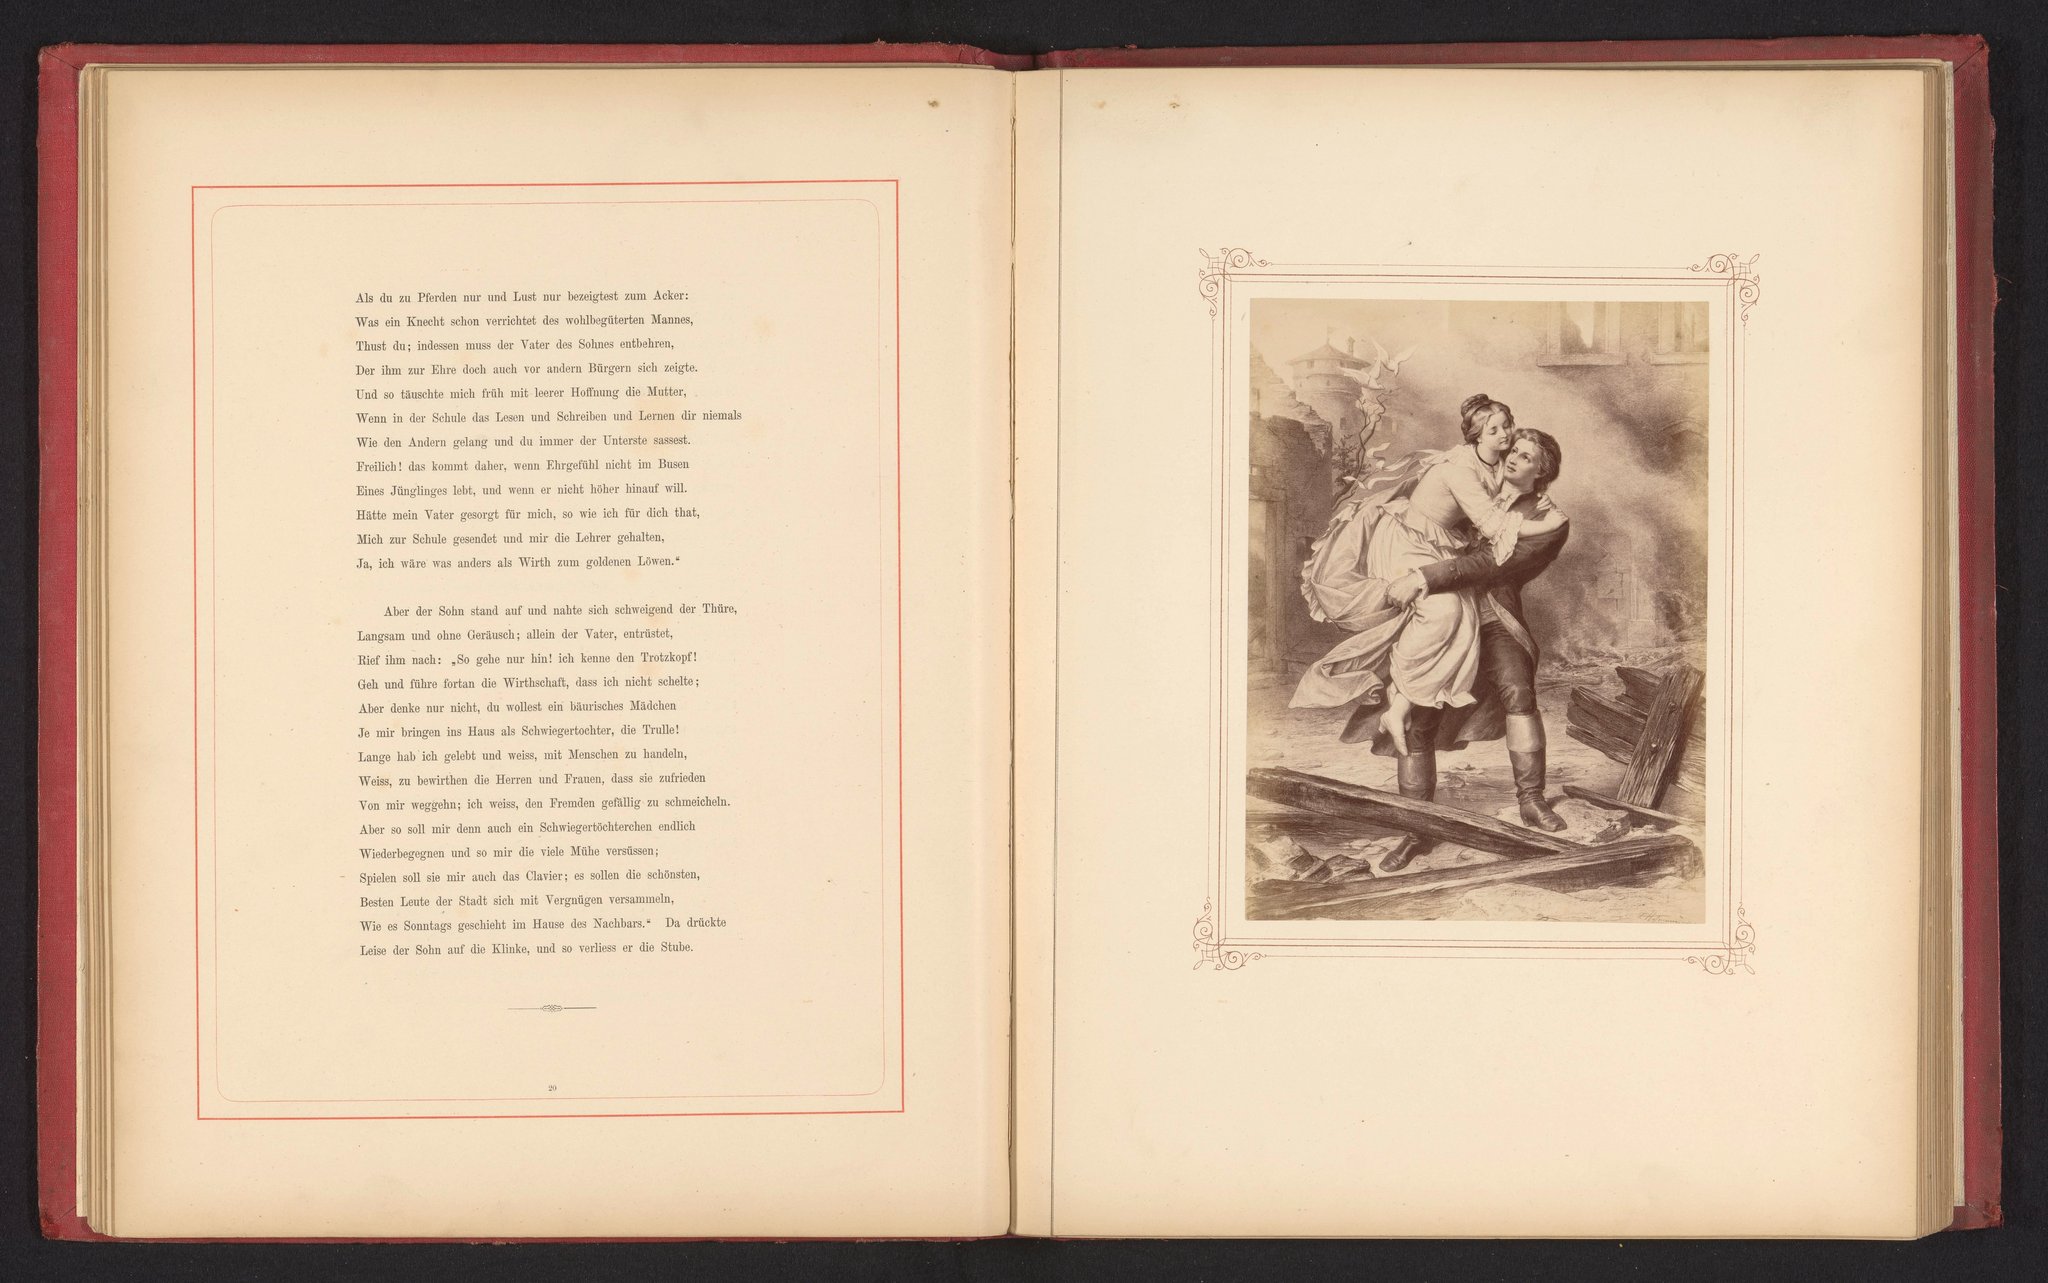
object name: reproduction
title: Fotoreproductie van een schilderij, voorstellende Hermann draagt Dorothea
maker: franz seraph hanfstaengl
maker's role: painter, print maker, printer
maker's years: 1804-1877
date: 1867-1872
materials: photographic support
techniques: albumen print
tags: adult woman, carrying a person, adult man